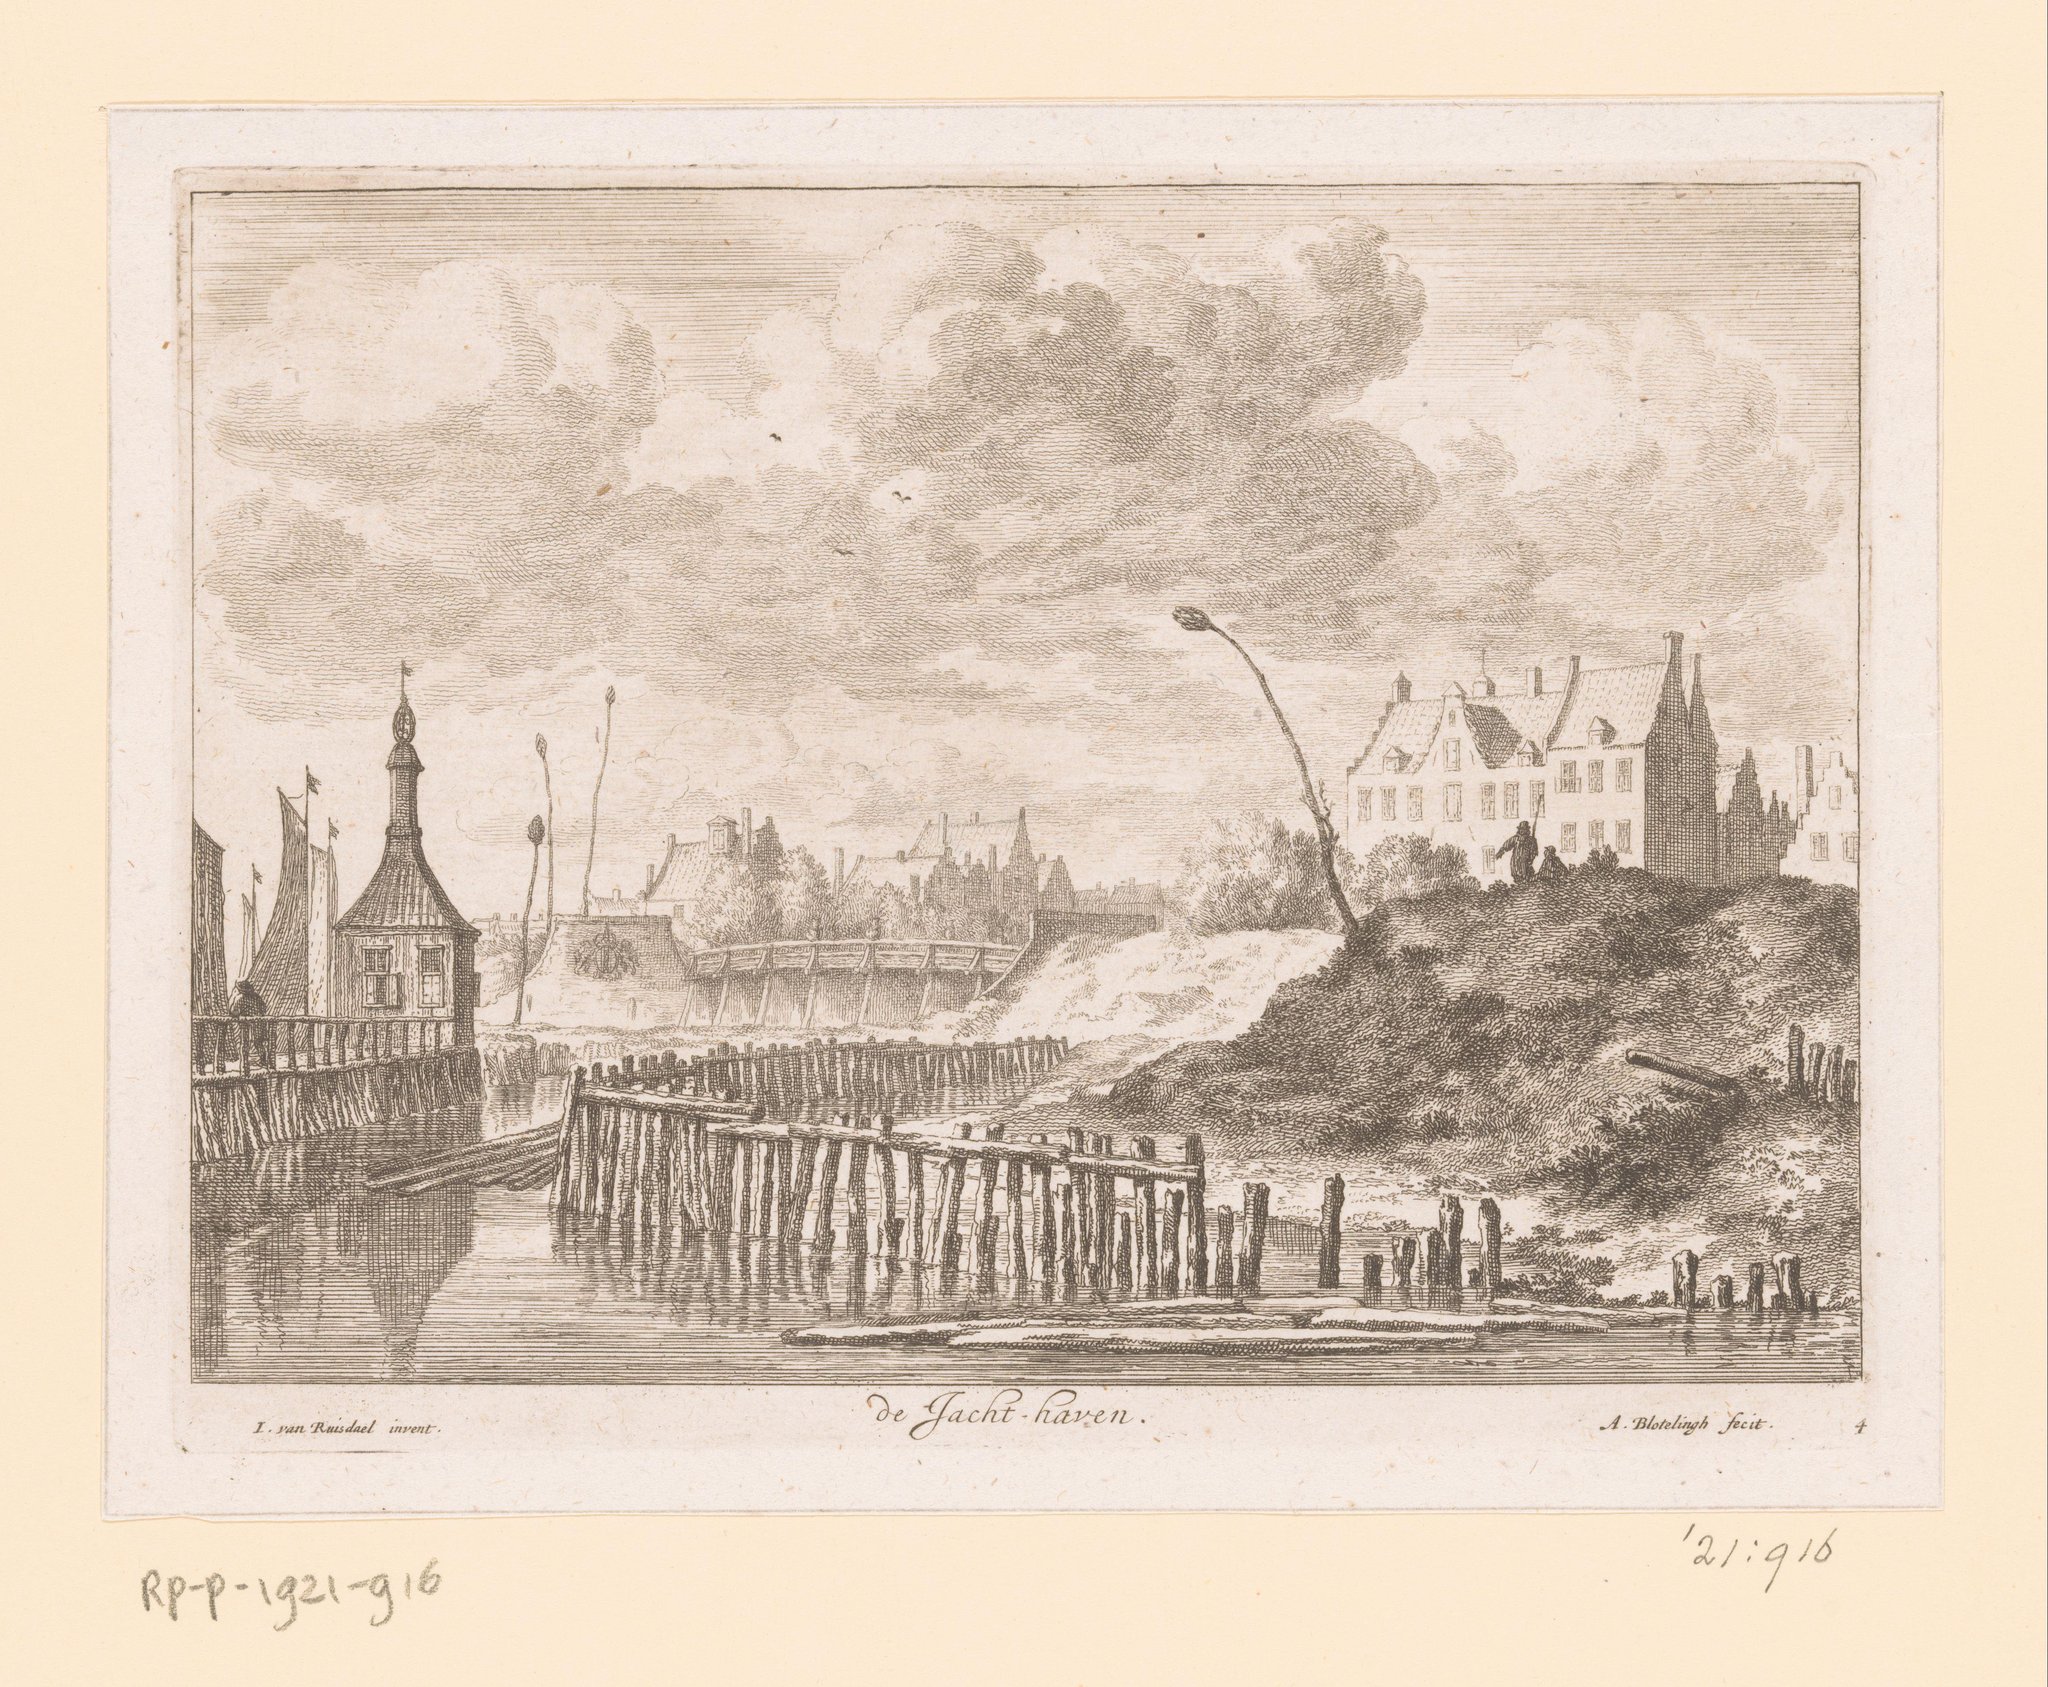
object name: print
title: De Jacht-haven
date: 1664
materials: paper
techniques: etching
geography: amsterdam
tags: city-view, and landscape with man-made constructions, canals, waters (in city)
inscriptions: collector's mark: Lugt 2610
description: Prent maakt deel uit van een serie van zes prenten die Abraham Bloteling maakte naar tekeningen van Jacob van Ruisdael.